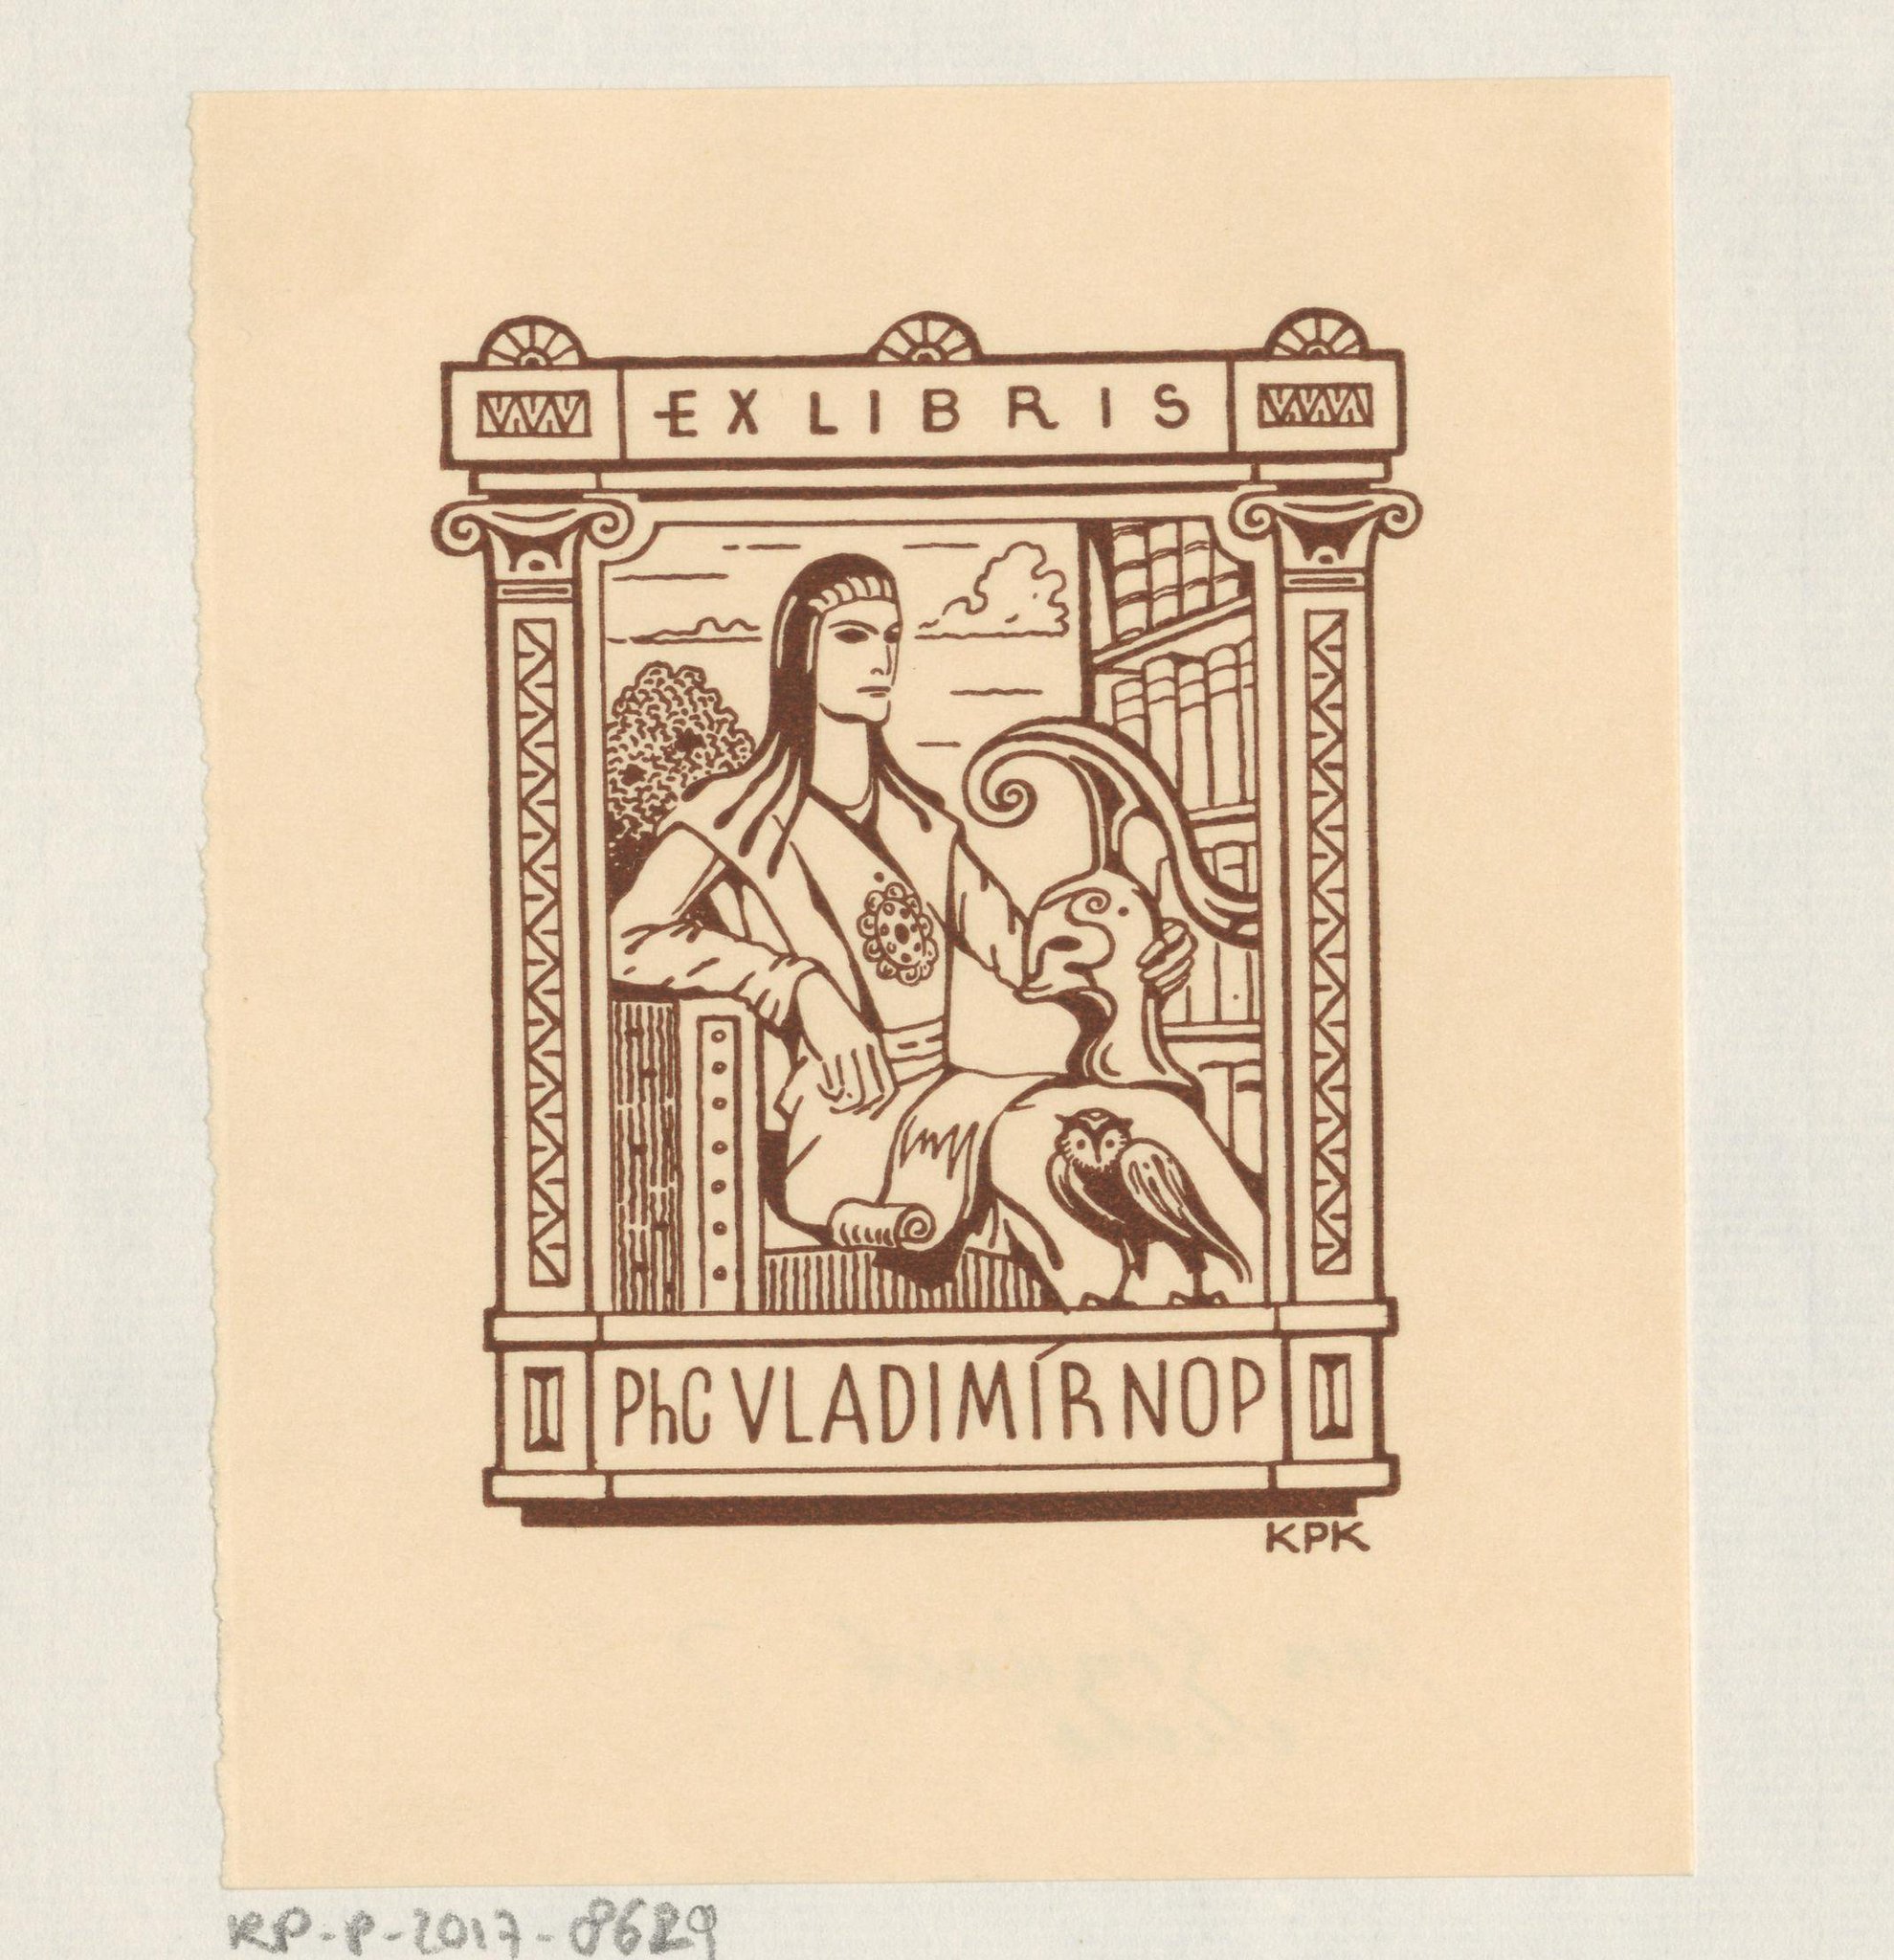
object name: bookplate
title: Ex libris van Vladimír Nop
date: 1893-1950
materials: paper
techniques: printing block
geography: czech republic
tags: bookshelves, sitting figure, gauntlet, armoured glove to protect the hand